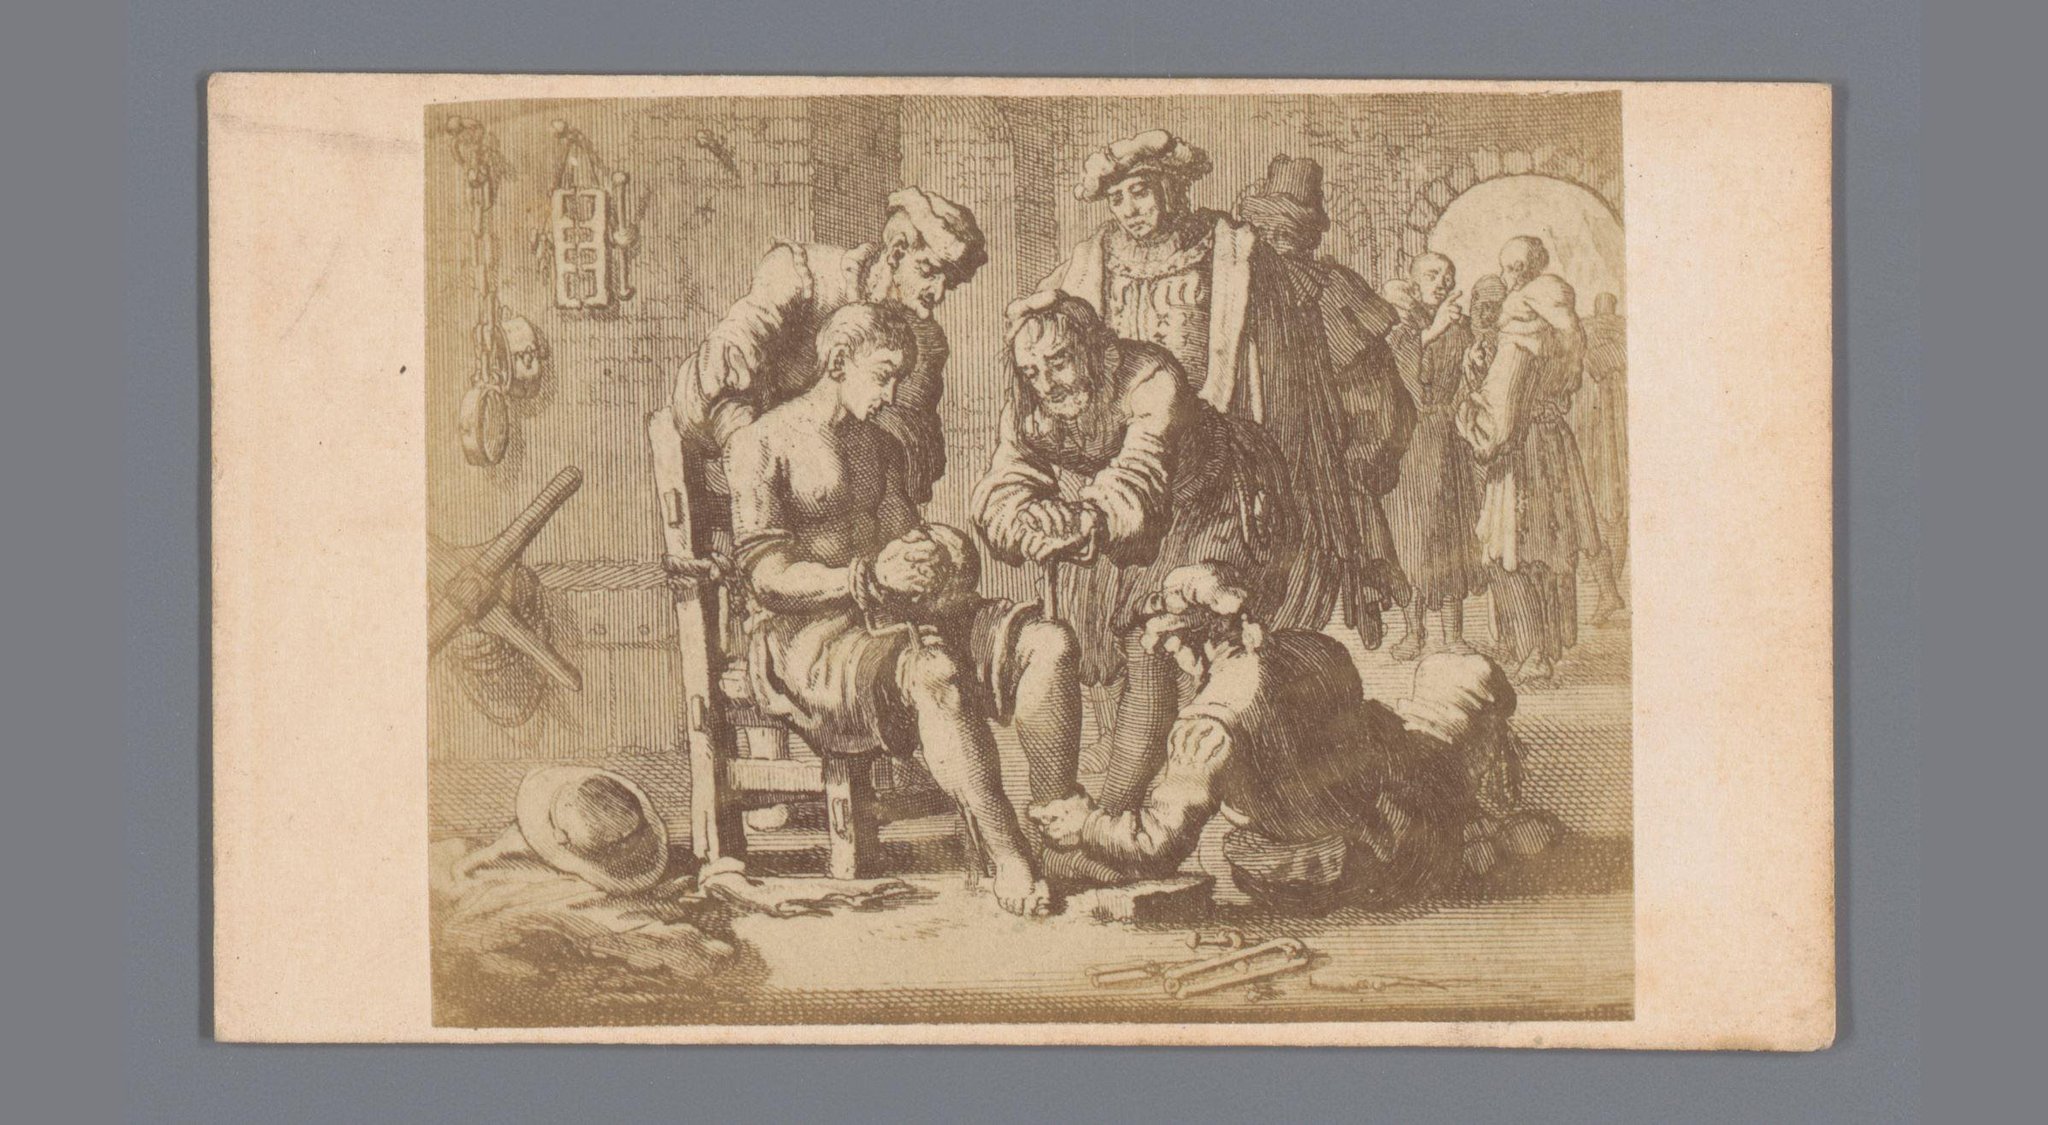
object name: photograph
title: De Spaansche Inquizitie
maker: Anonymous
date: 1855-1900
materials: cardboard, paper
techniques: albumen print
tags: prison, jail, violent death by mutilation or maiming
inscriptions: inscription: ‘De voltrekking van de doodvonnissen (...) in het jaar 1560.’, number: ‘No. 4.’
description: De oorspronkelijke prent van Jan Luyken is van 1685. Zie ook RP-P-OB-44.285.